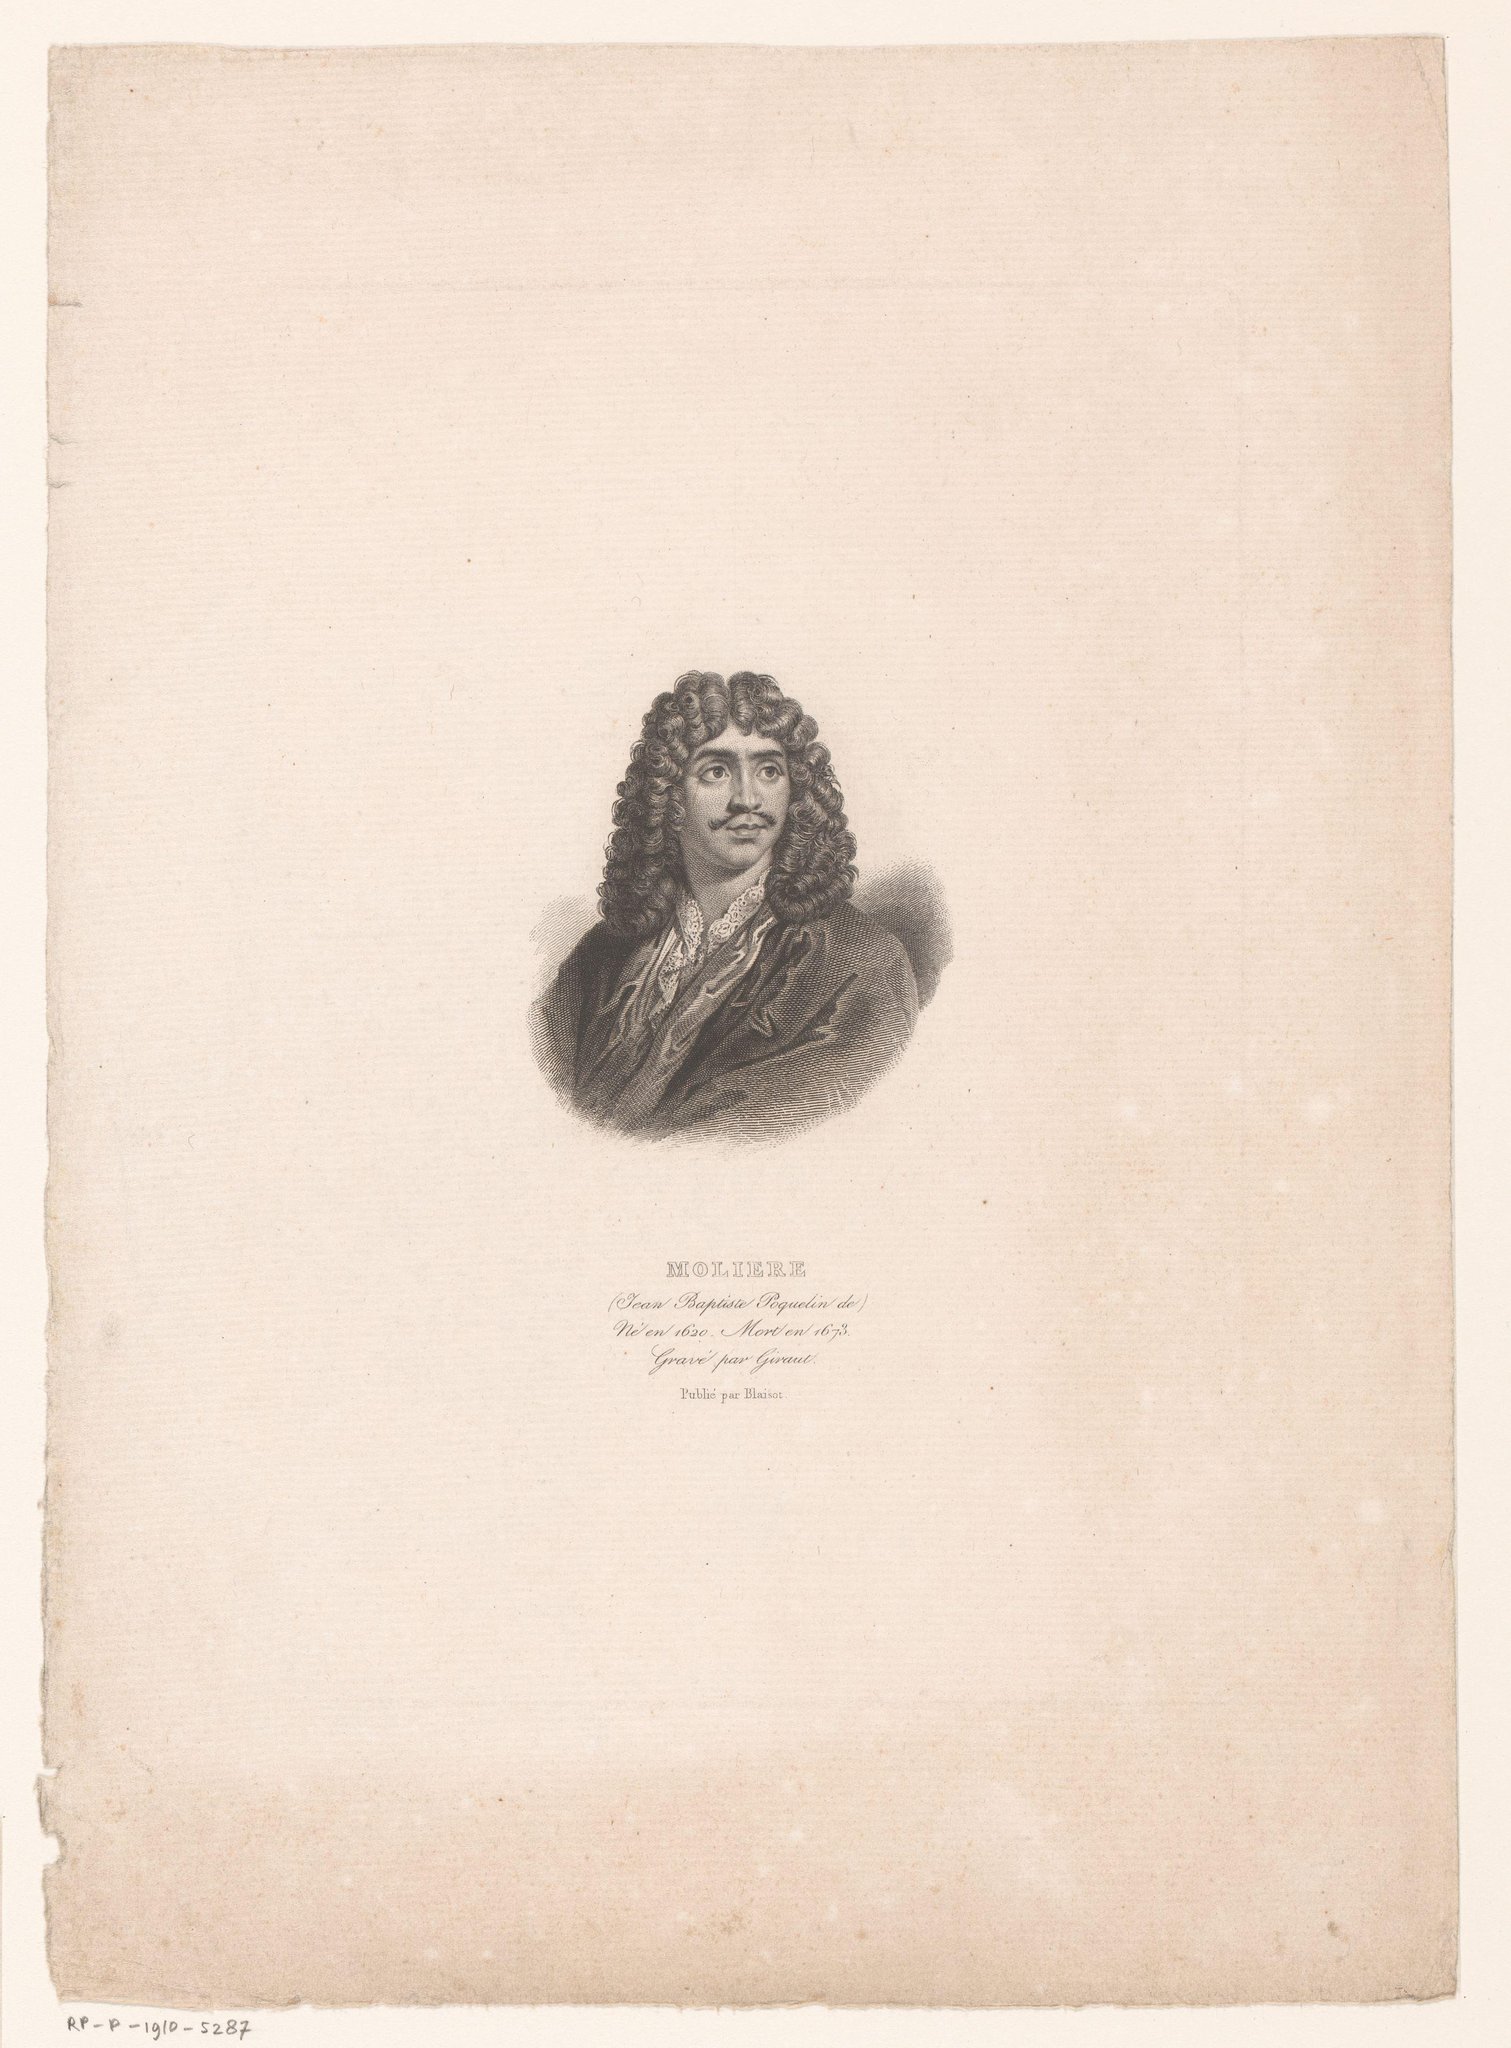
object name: print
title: Portret van Jean Baptiste Poquelin Molière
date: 1770-1810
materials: paper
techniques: engraving, etching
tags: paris, jean baptiste poquelin molière, historical persons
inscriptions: collector's mark: Lugt 2228